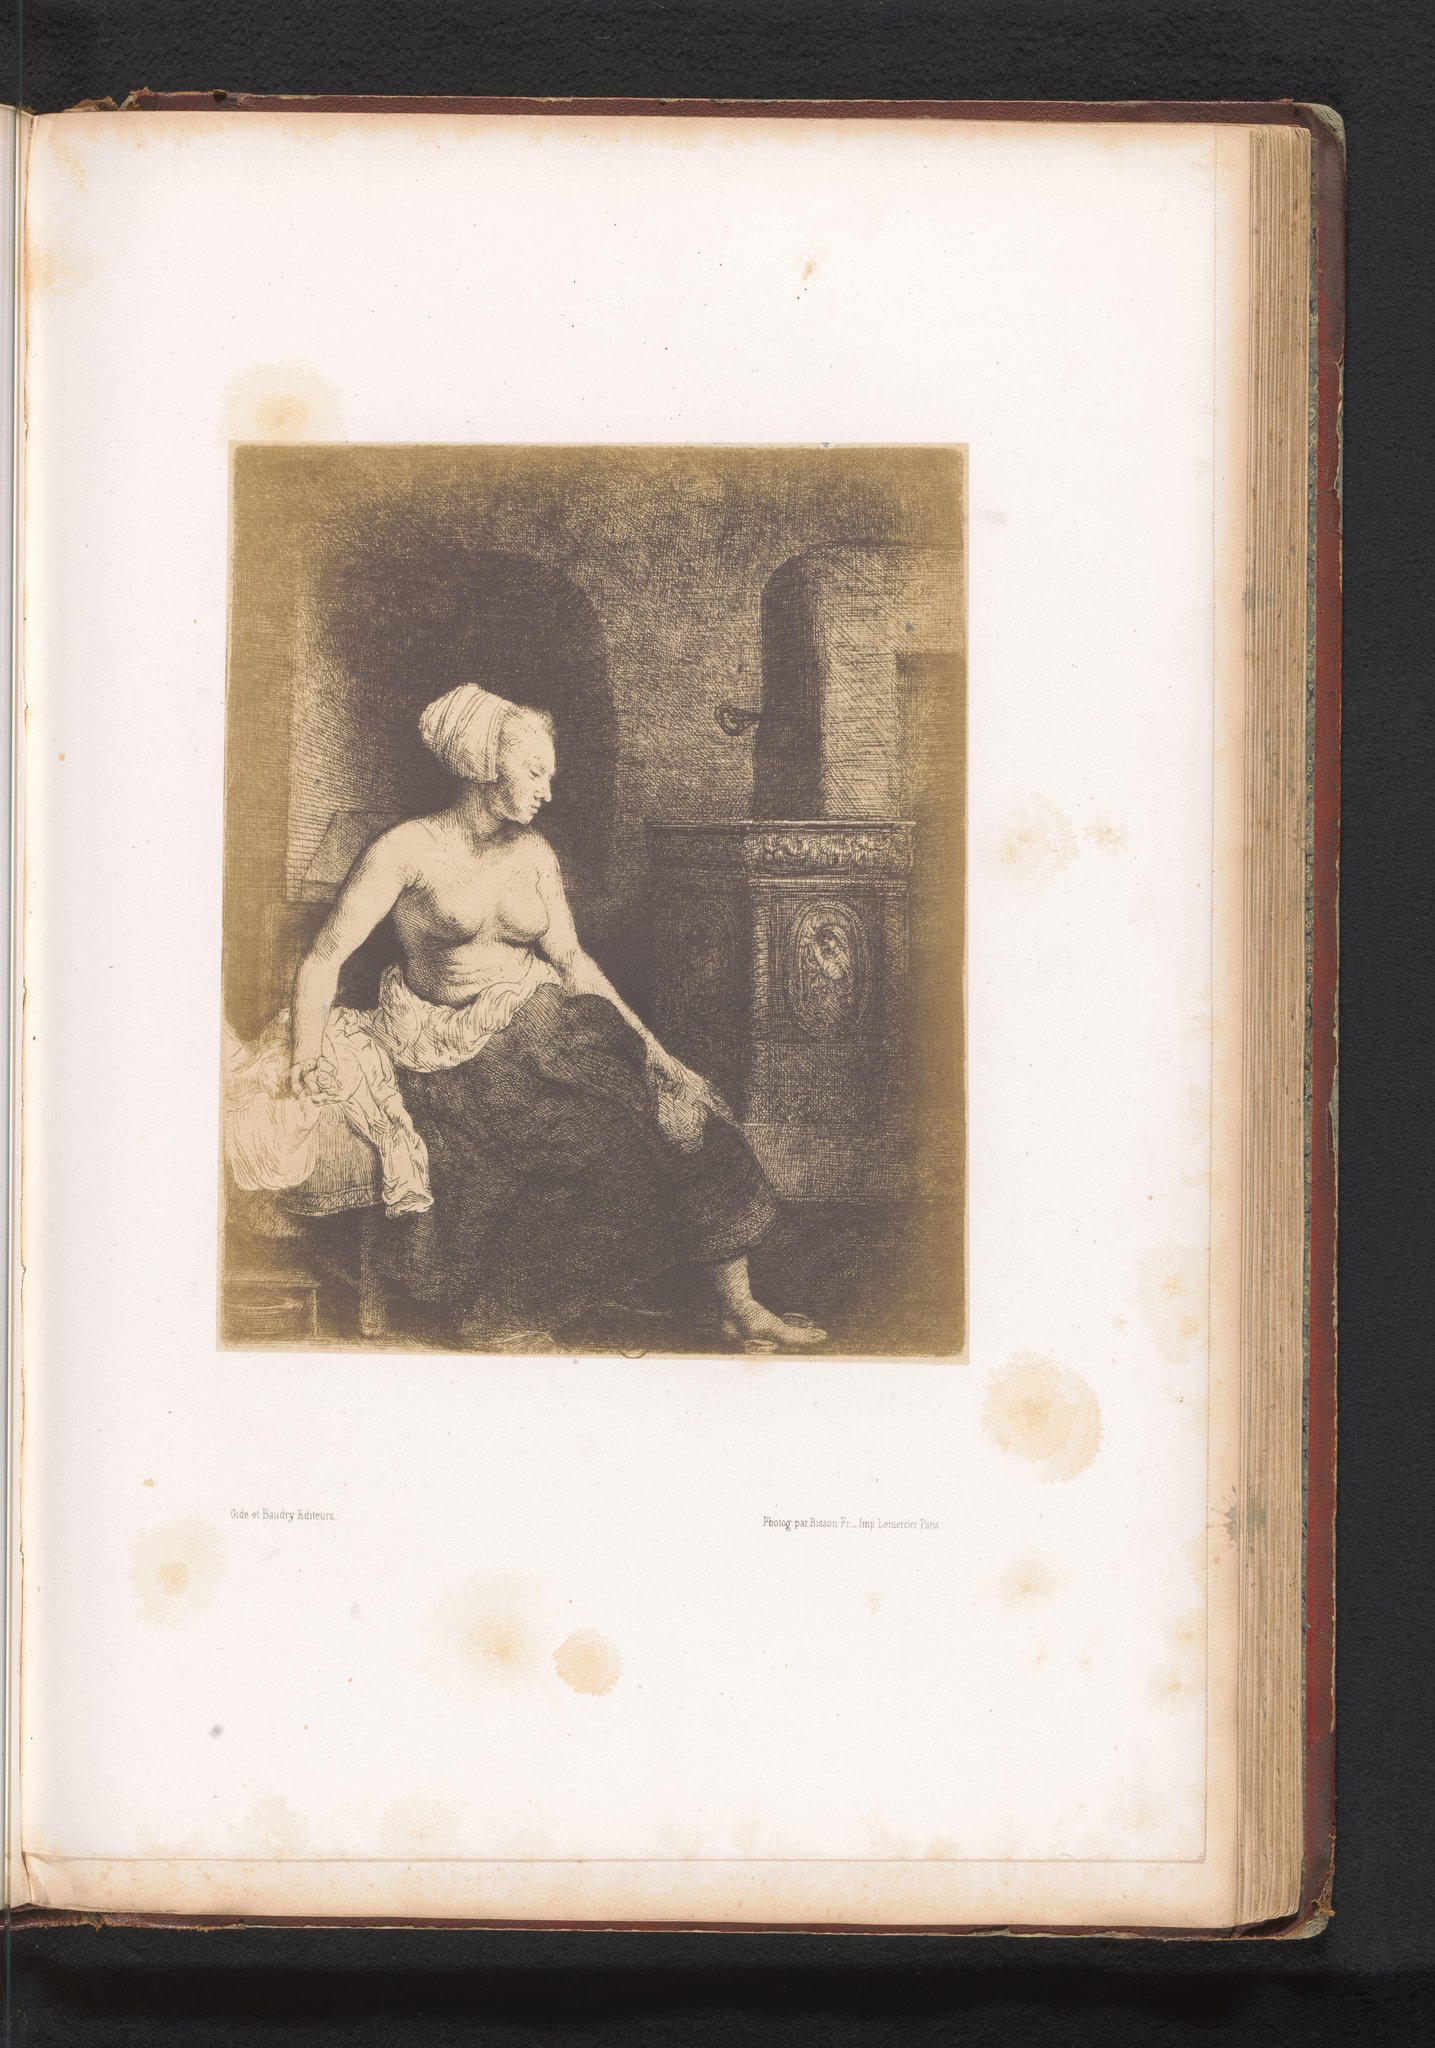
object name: photograph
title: Fotoreproductie van een ets van een vrouw met ontbloot bovenlichaam bij een kachel door Rembrandt van Rijn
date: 1848-1853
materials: photographic support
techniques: salted paper print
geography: paris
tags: woman (showing herself) undressed, quasi-nude, heating stove